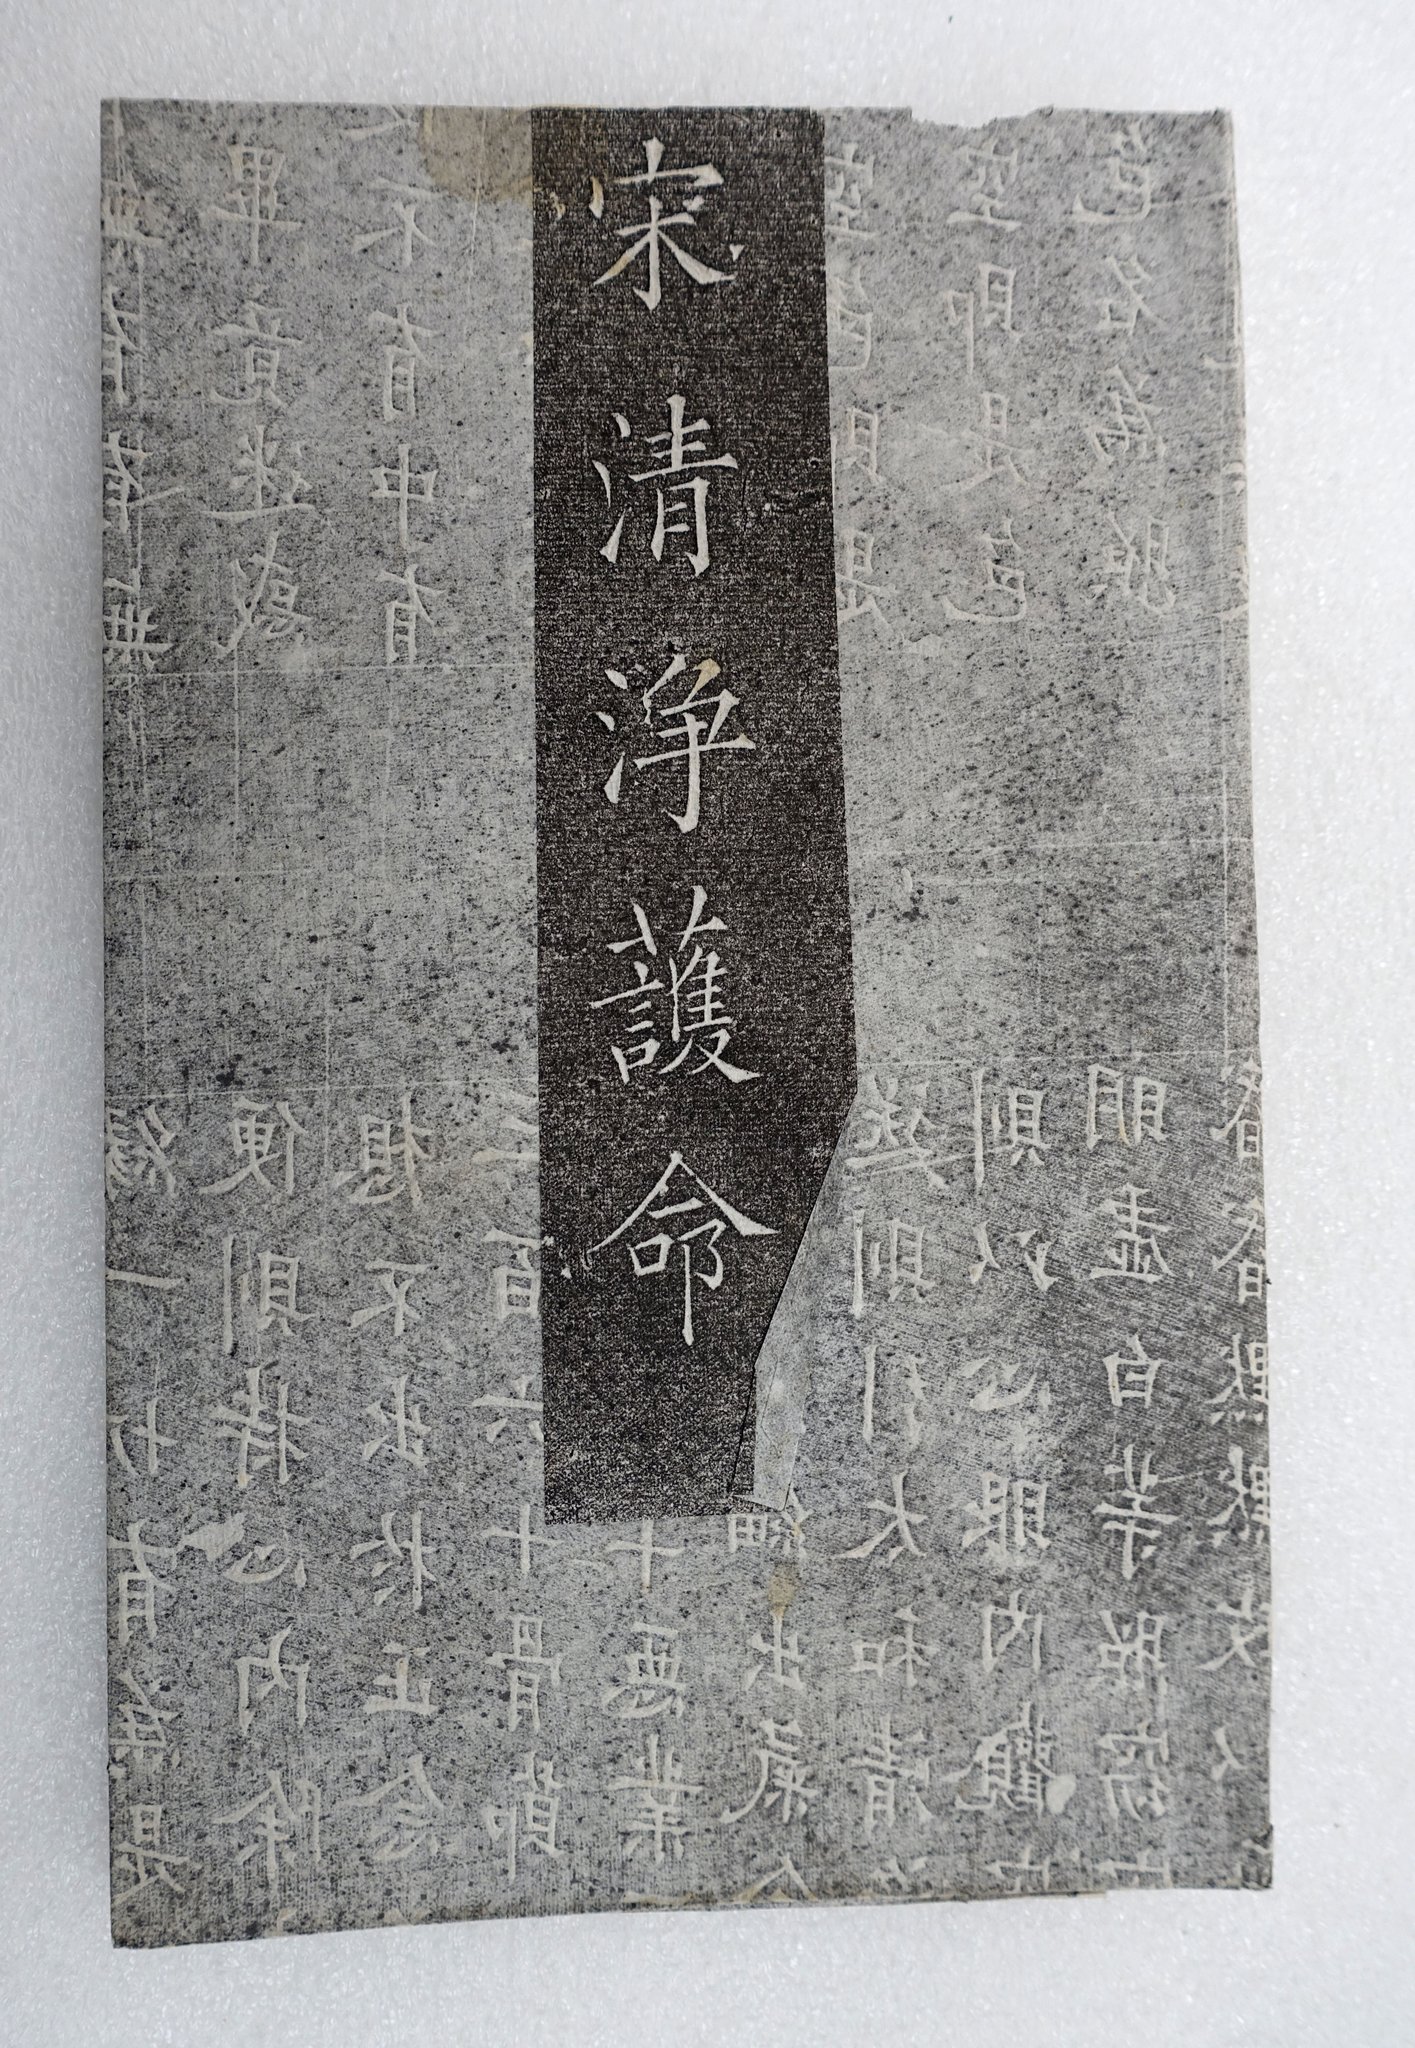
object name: rubbing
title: Three Taoist Scriptures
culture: chinese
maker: bai tingcan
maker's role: artist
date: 1901-2000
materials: ink, paper